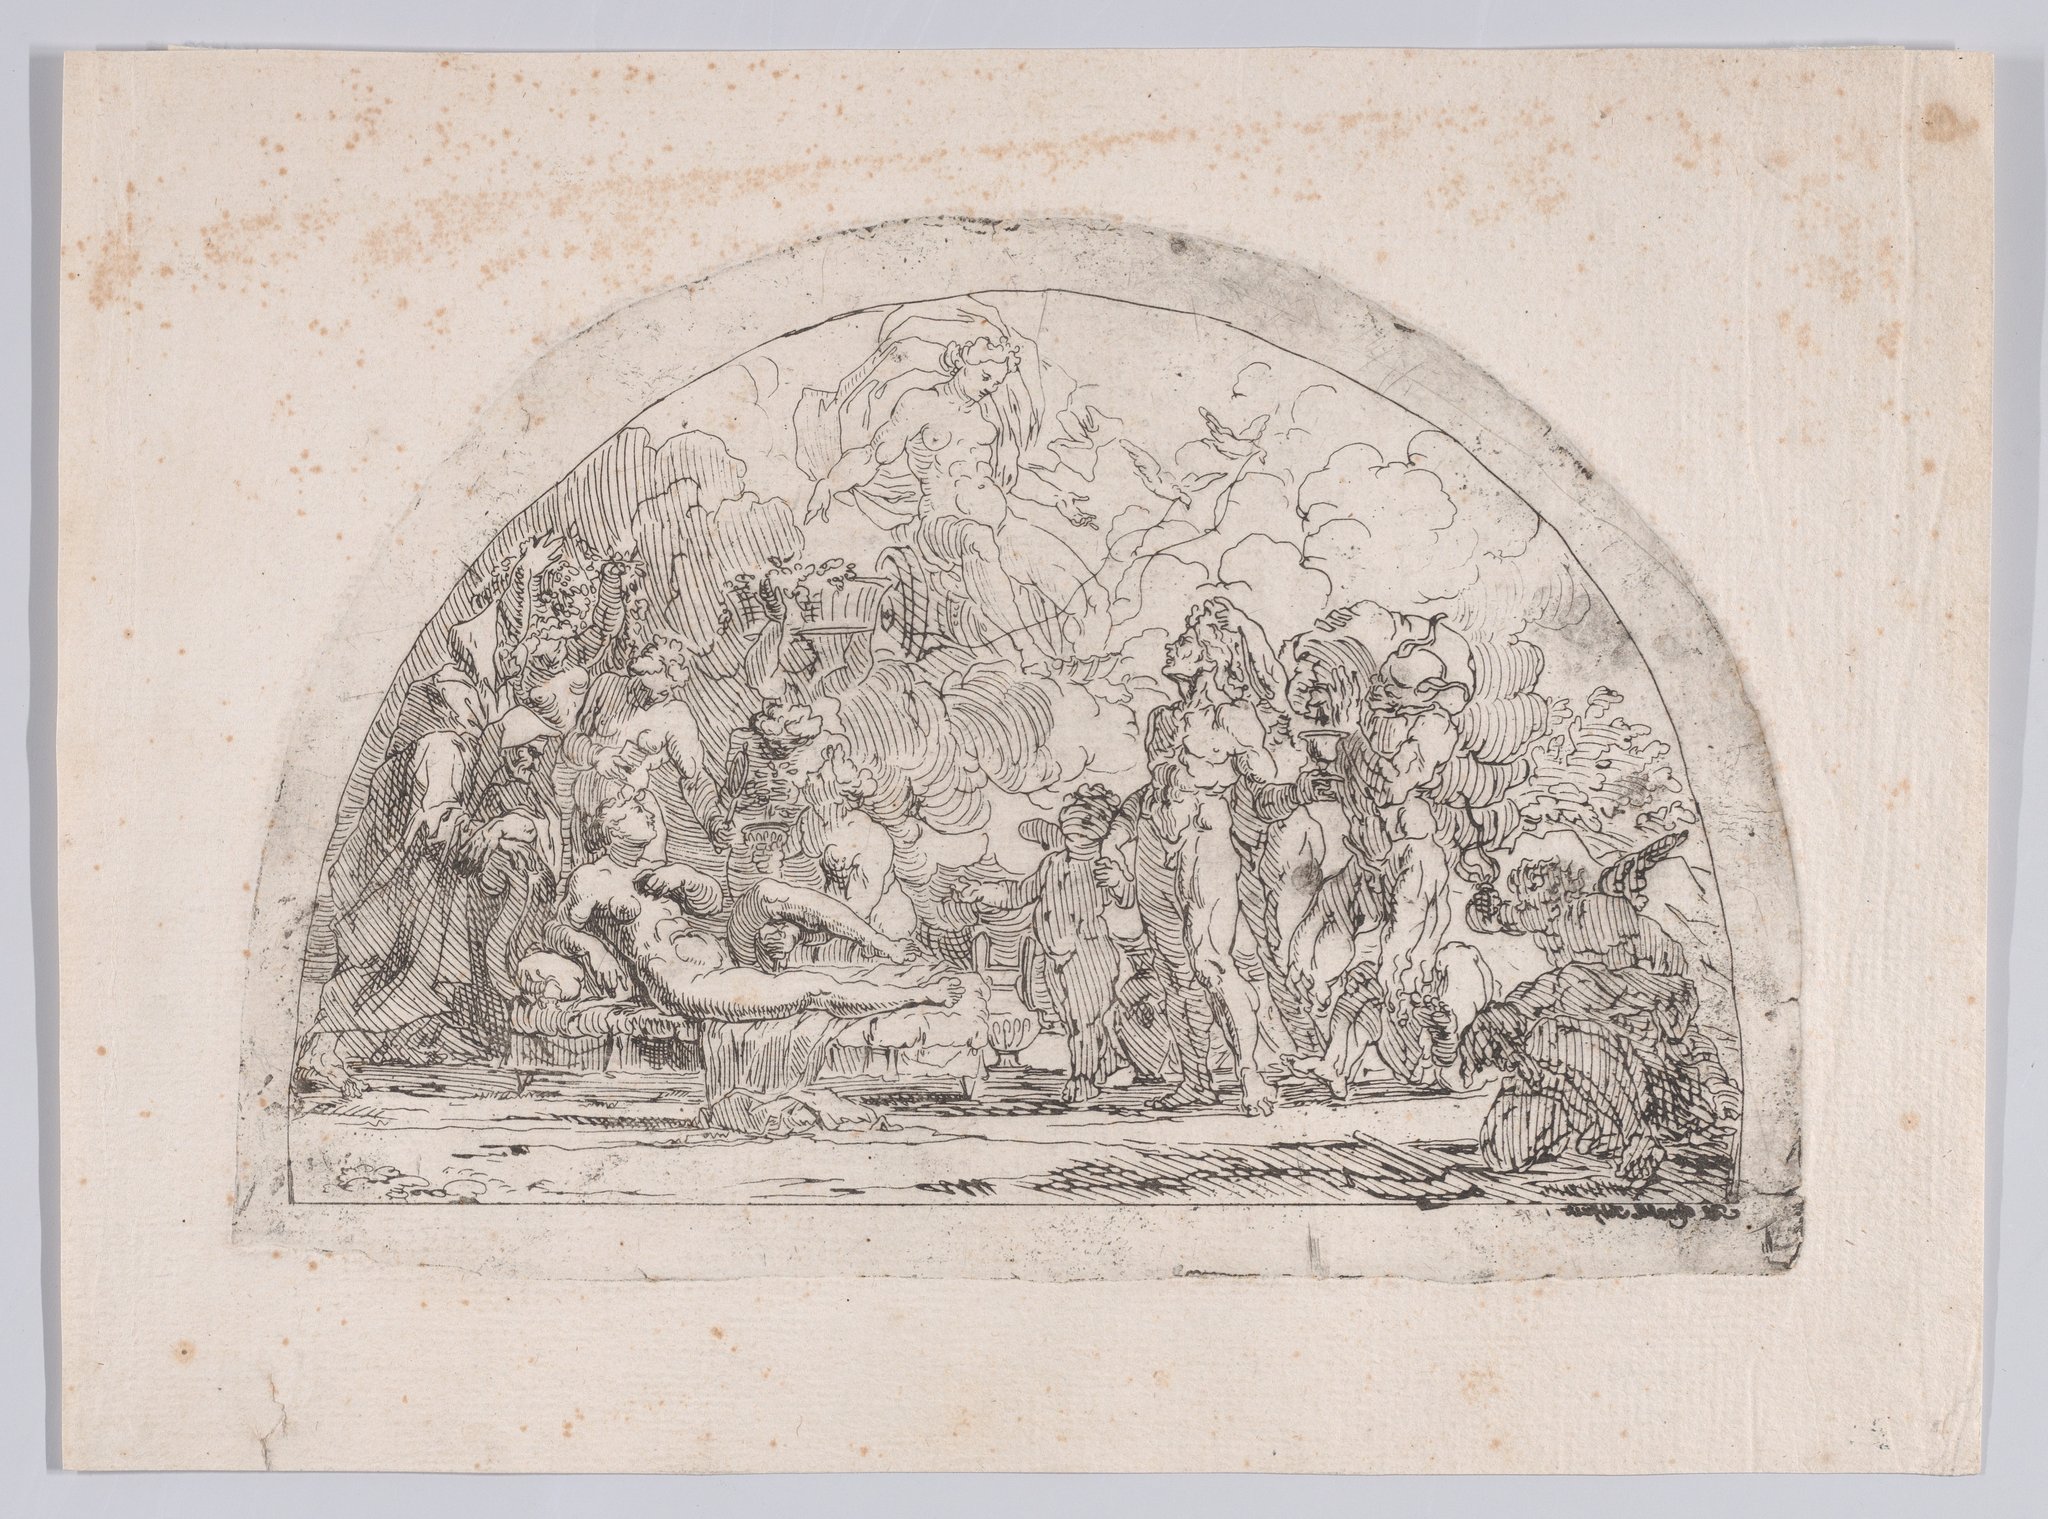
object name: print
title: Triumph of Bacchus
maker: erasmus quellinus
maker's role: artist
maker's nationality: flemish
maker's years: 1607-1678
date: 1607-1678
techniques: etching